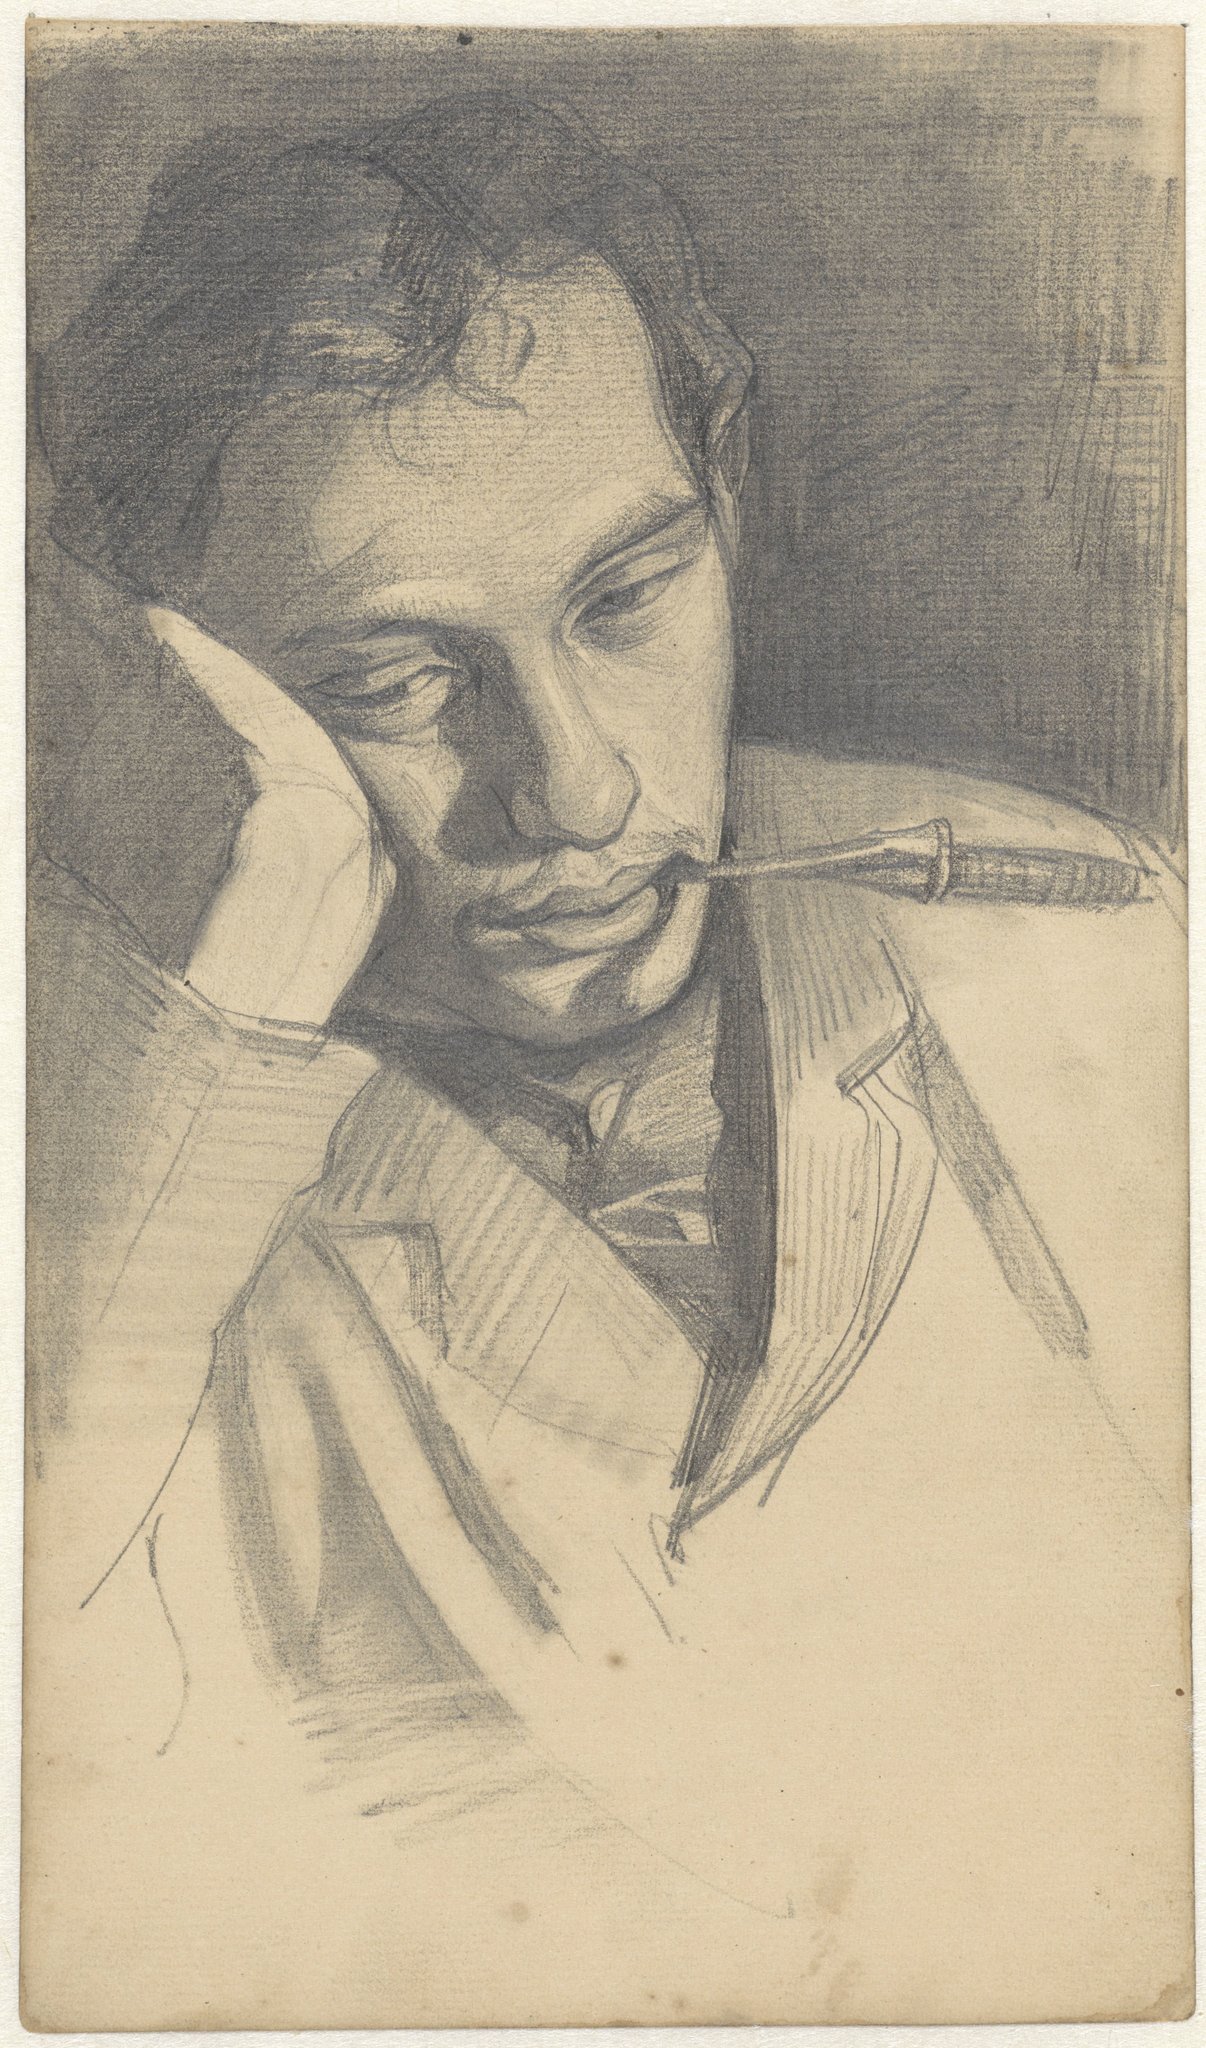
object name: drawing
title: Peinzende jongeman met sigarenpijpje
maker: jac van looij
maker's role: draughtsman, painter, print maker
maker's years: 1855-1930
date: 1865-1930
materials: paper, pencil